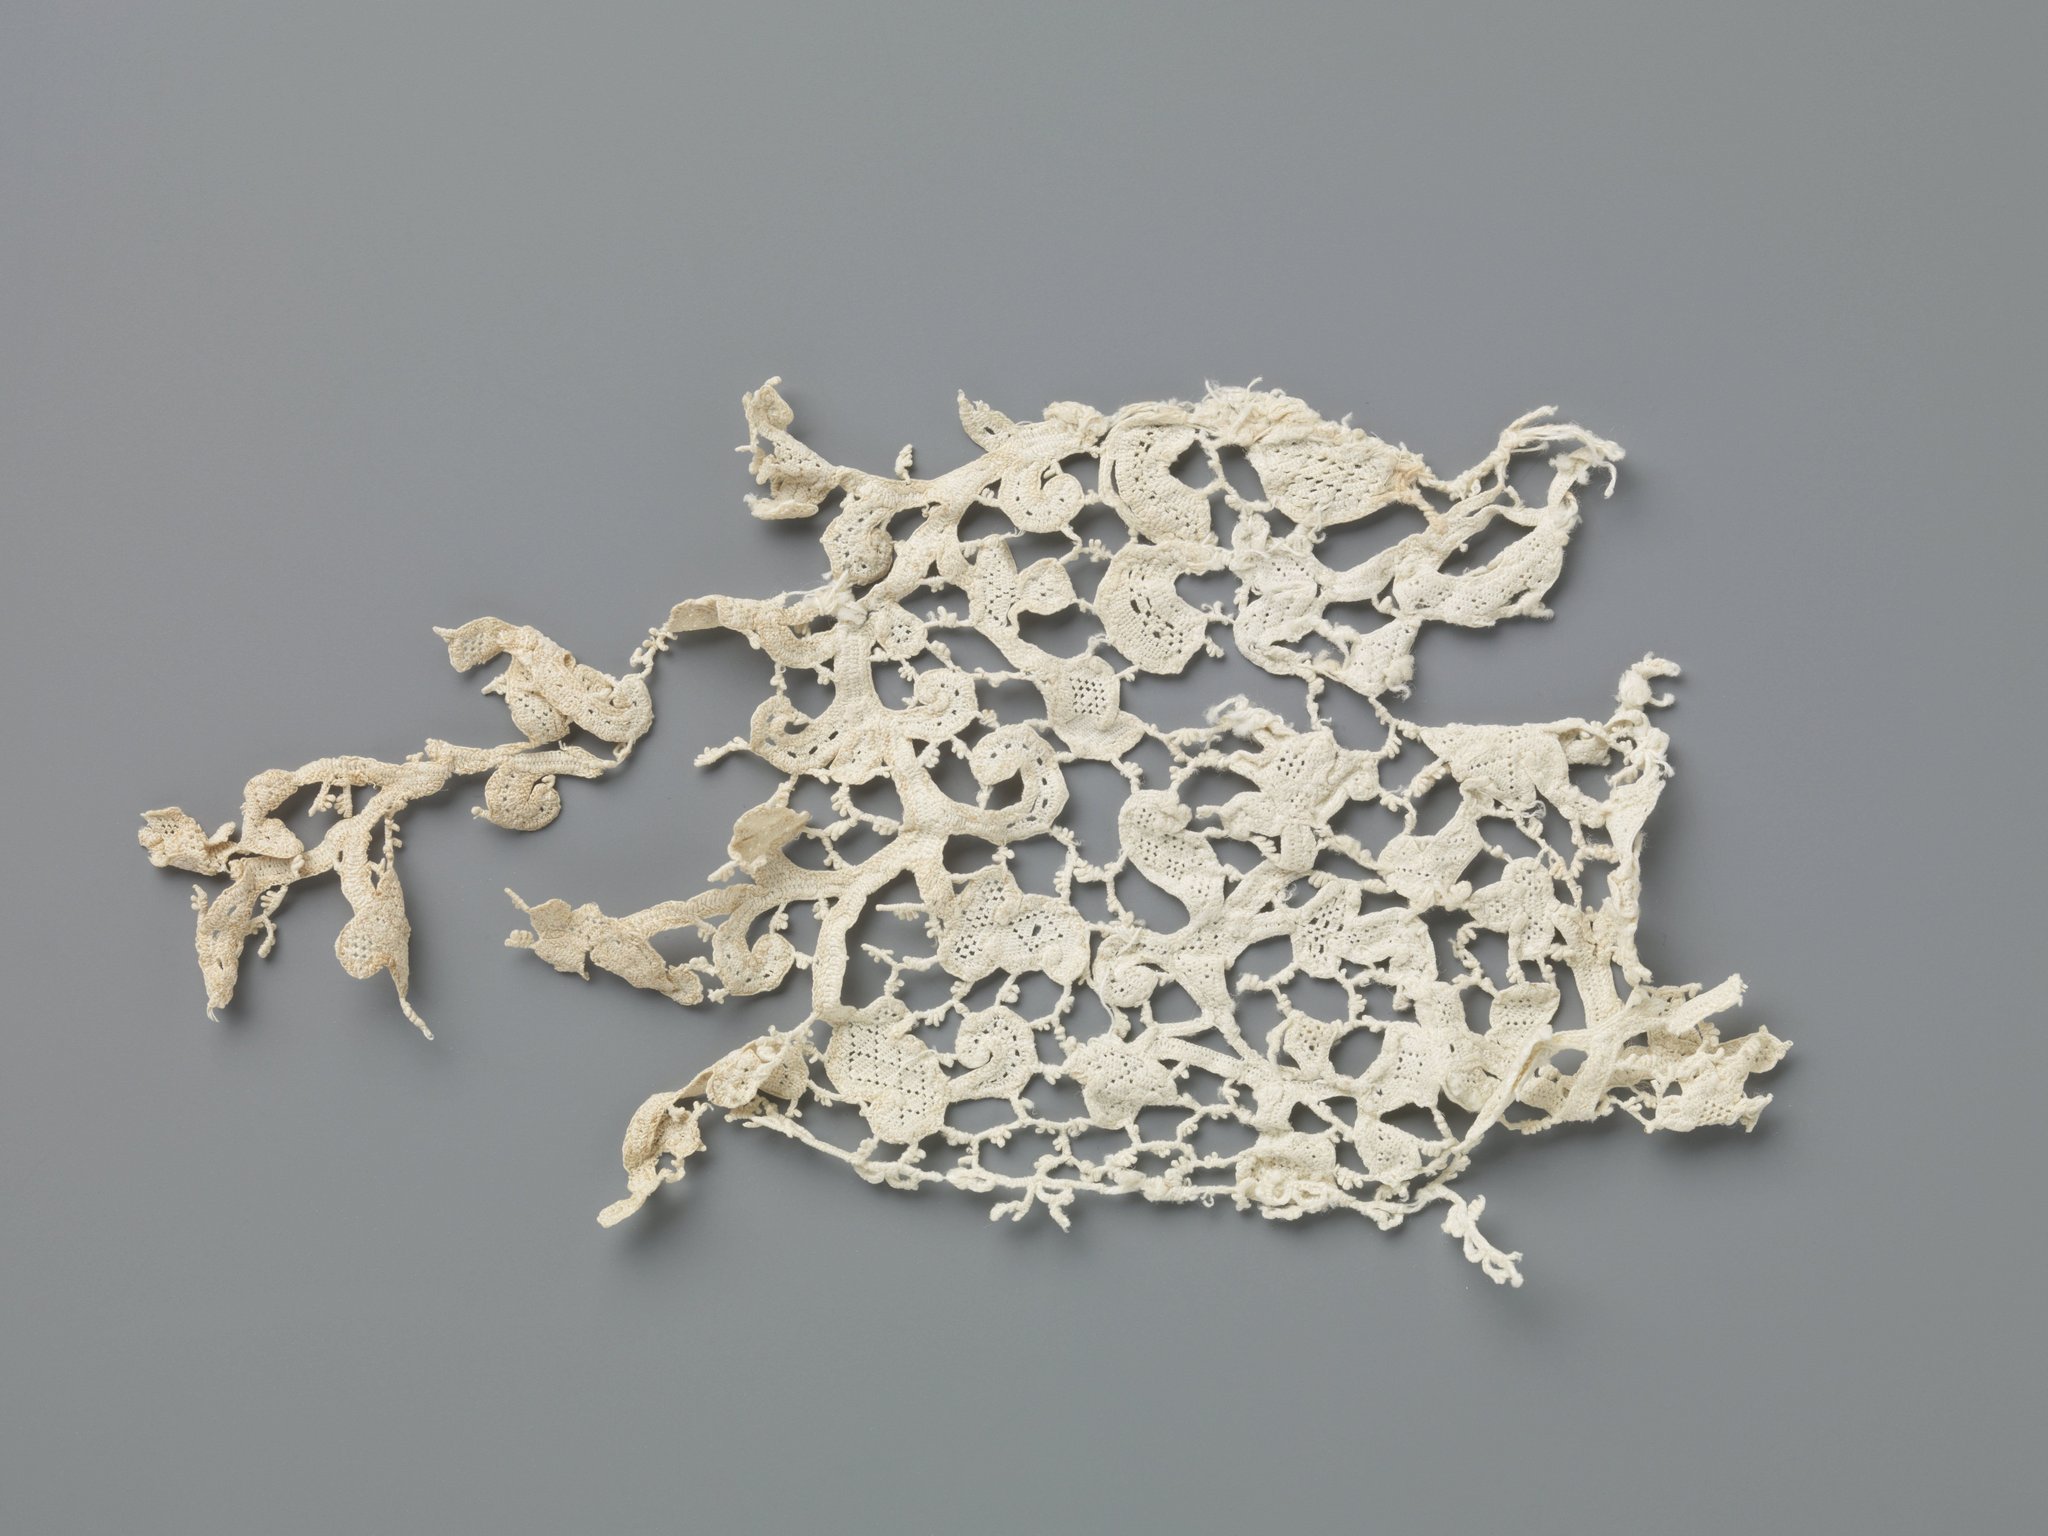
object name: strip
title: Strook naaldkant met krullende ranken en veelsoortige bloemen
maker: Anonymous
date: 1700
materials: linen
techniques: flat venetian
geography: venice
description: Strook naturelkleurig naaldkant, Venise plat. Patroon met rijk vertakte krullende ranken met kleine veelsoortige bloemen op een onregelmatige open grond met eenzijdig gepicoteerde spijlen. Volwerk met gedraaide festonsteken met daarin verschillende motieven doormiddel van uitsparingen. De bovenzijde was oorspronkelijk afgezet met een rand kloskant, door beschadiging ontbreekt deze afwerking. De onderzijde is afgewerkt met een rechte picotrand met boogjes.